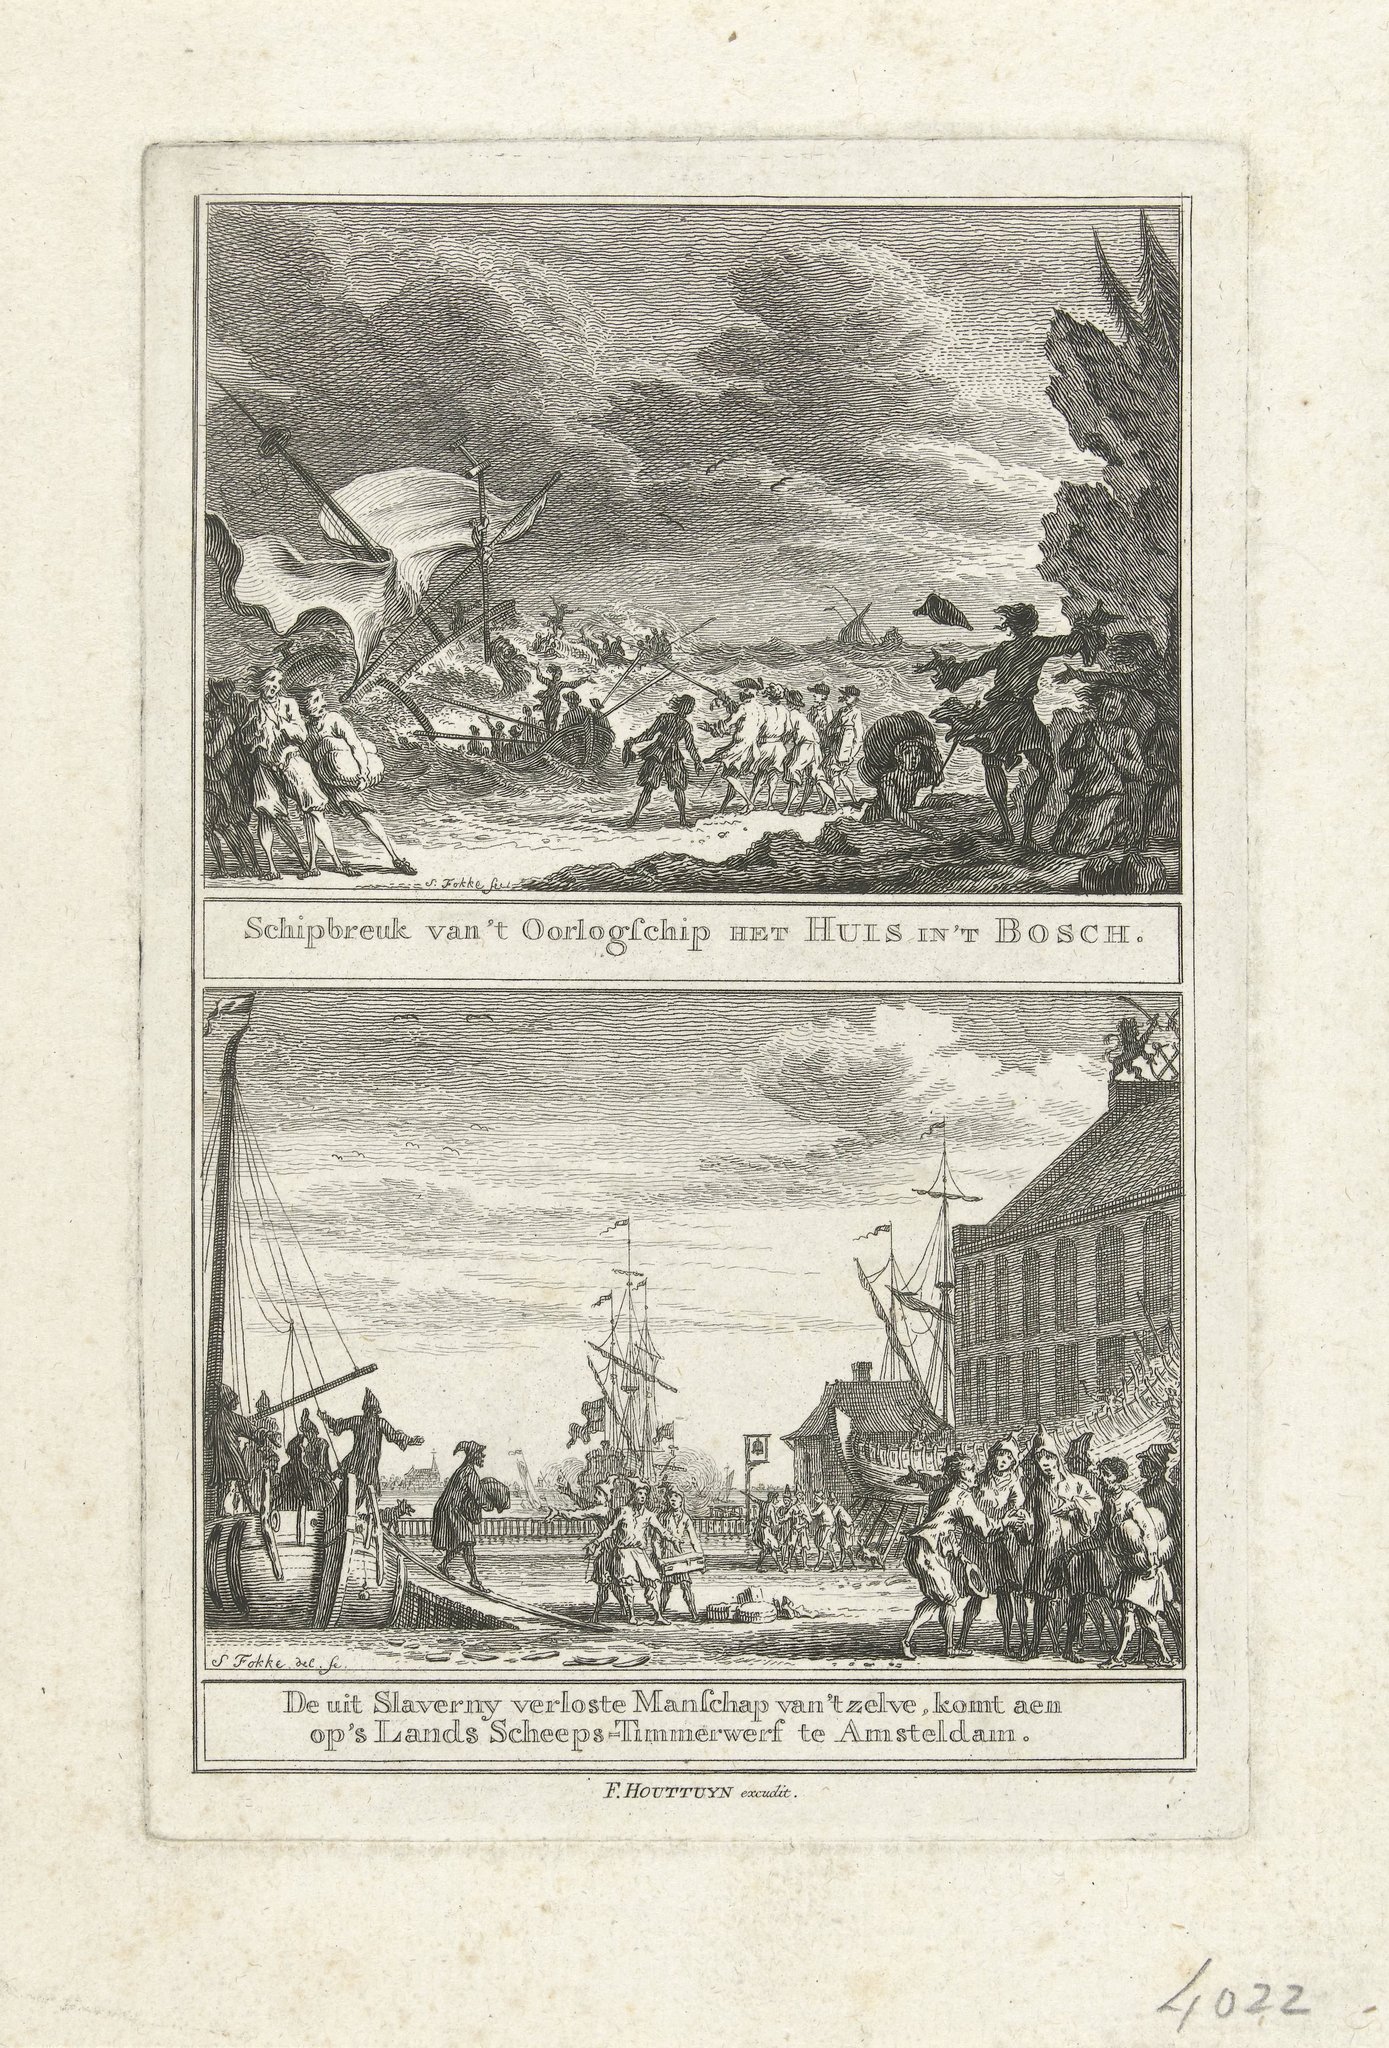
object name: print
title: Schipbreuk van 't oorlogschip Het Huis in 't Bosch / De uit slaverny verloste manschap van 't zelve, komt aen op 's Lands Scheeps-Timmerwerf te Amsteldam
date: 1753-1754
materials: paper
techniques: engraving, etching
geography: amsterdam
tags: shipwreck, slavery; serfs and enslaved persons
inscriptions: collector's mark: Lugt 240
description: Blad met twee voorstellingen. Boven: de schipbreuk van het oorlogsschip Het Huis in 't Bosch onder kapitein H.C. Steenis voor de kust van Marokko op 20 december 1751. Na de schipbreuk was de bemanning door Noord-Afrikaanse kapers tot slaaf gemaakt. Dergelijke slaafgemaakten stonden bekend als 'christenslaven'. Onder: de terugkeer van de uit slavernij losgekochte bemanning van dat schip bij de Admiraliteitswerf te Amsterdam op 23 februari 1753.